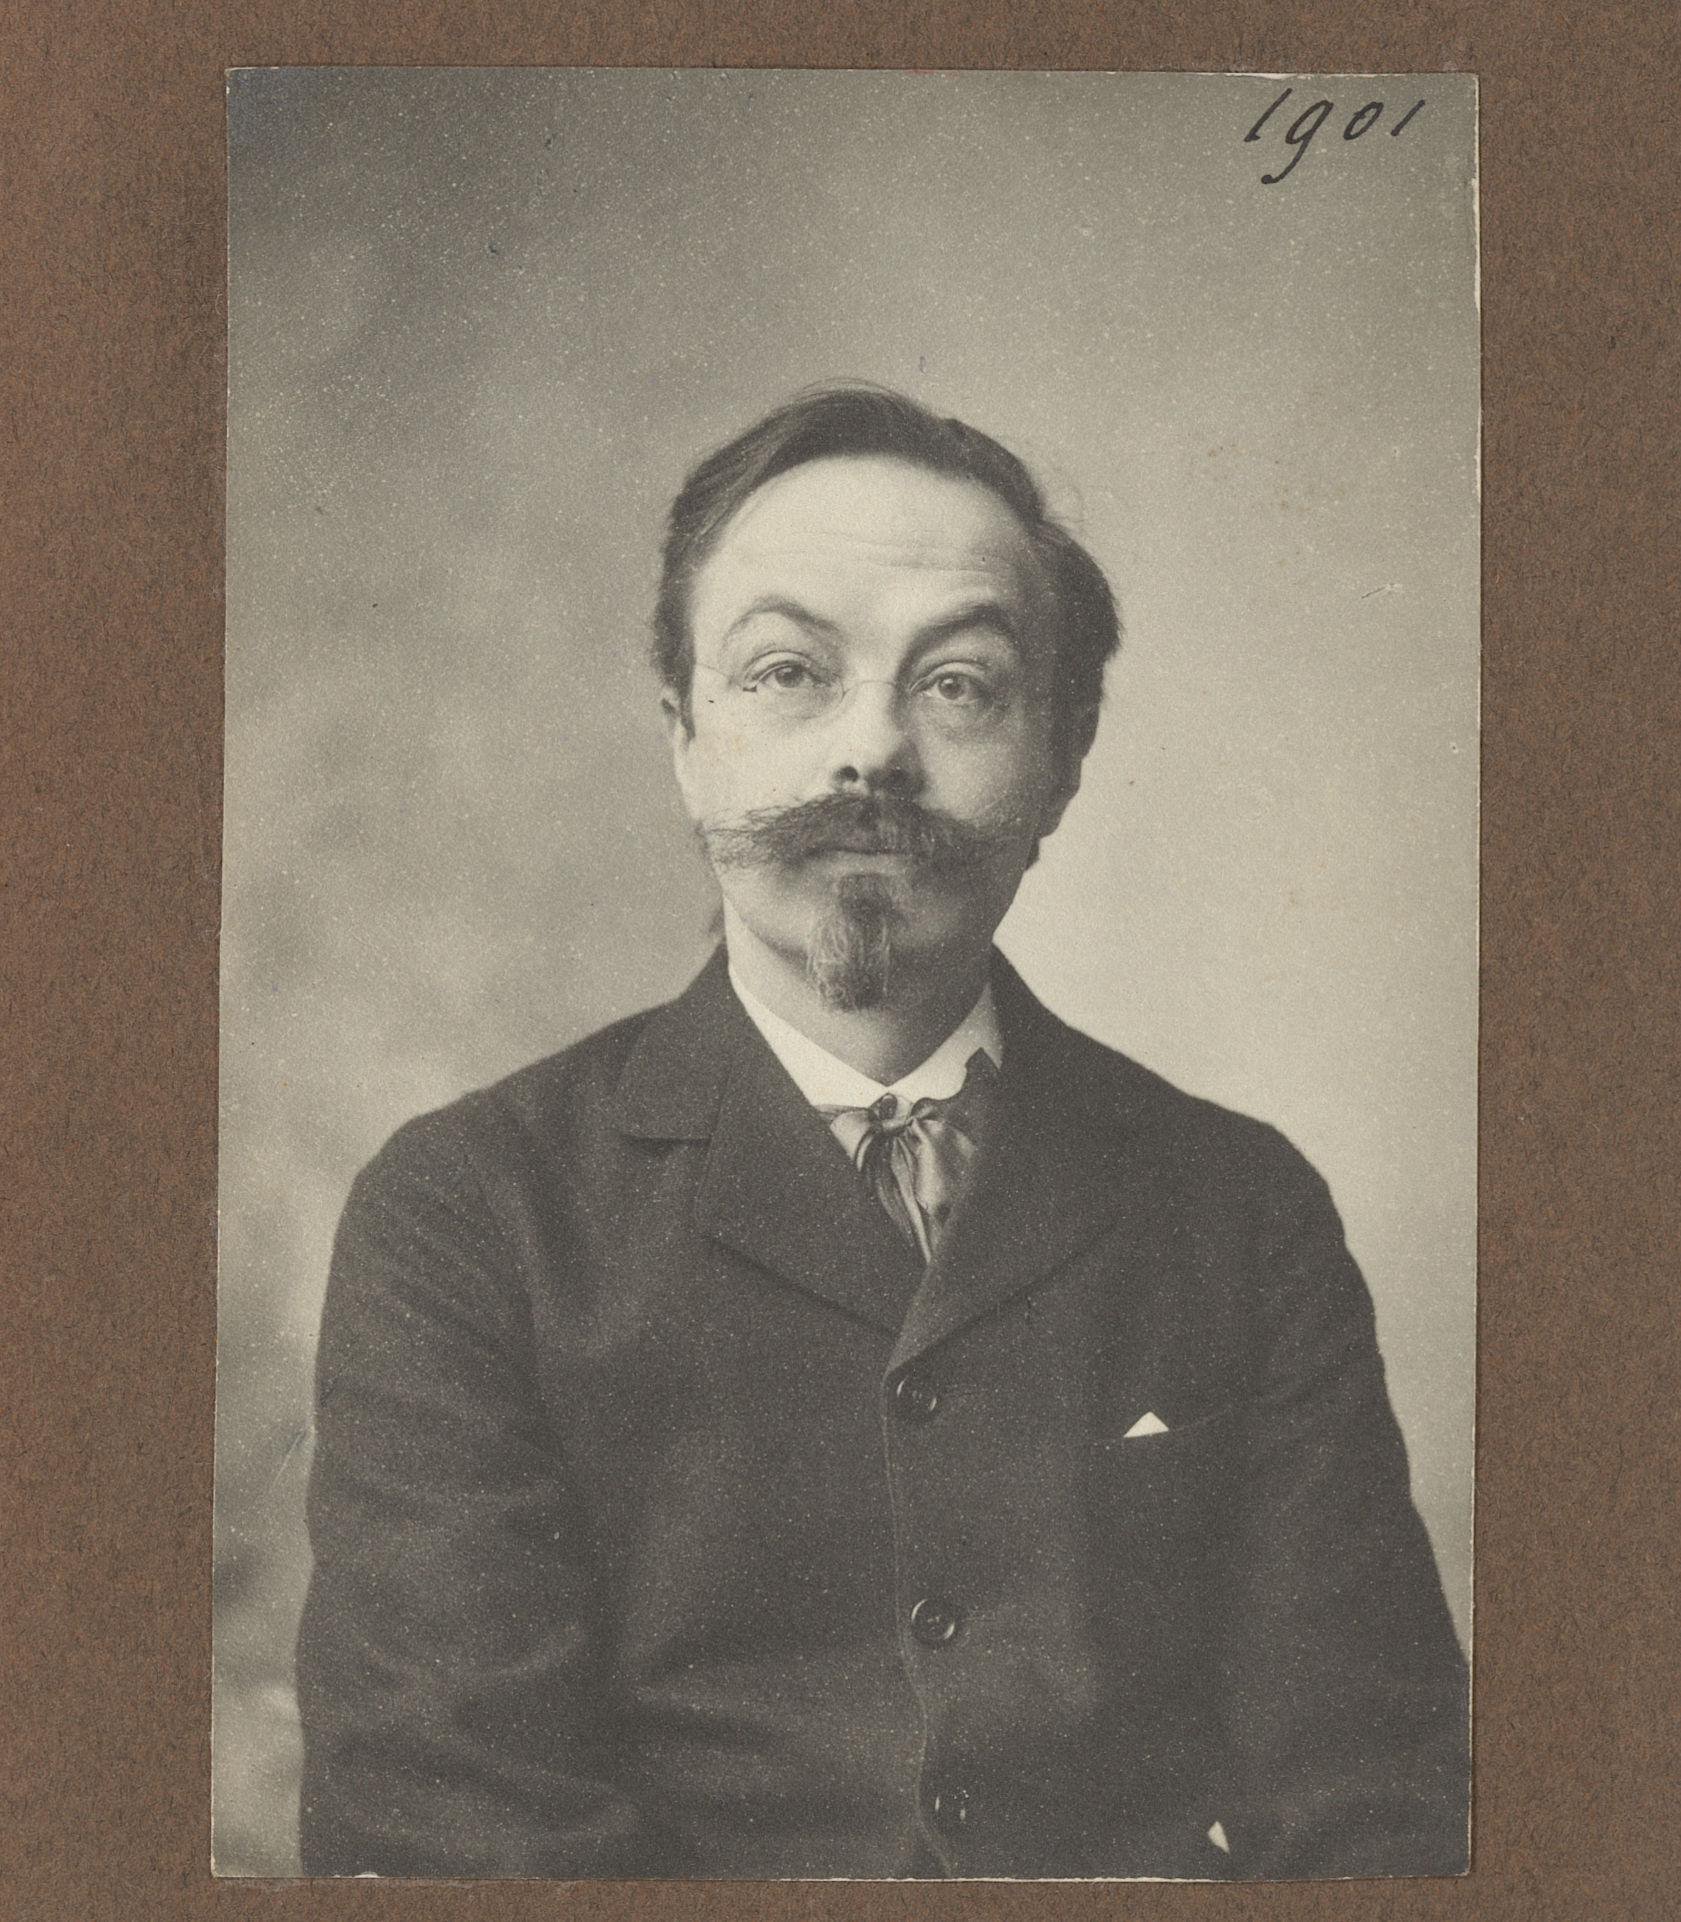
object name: photograph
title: Alphons Diepenbrock met snor en sik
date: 1901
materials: photographic support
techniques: photography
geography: netherlands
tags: amsterdam, alphons diepenbrock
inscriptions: date: ‘1901’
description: Foto op bruin albumblad 14 van familiealbum van Alphons Diepenbrock.